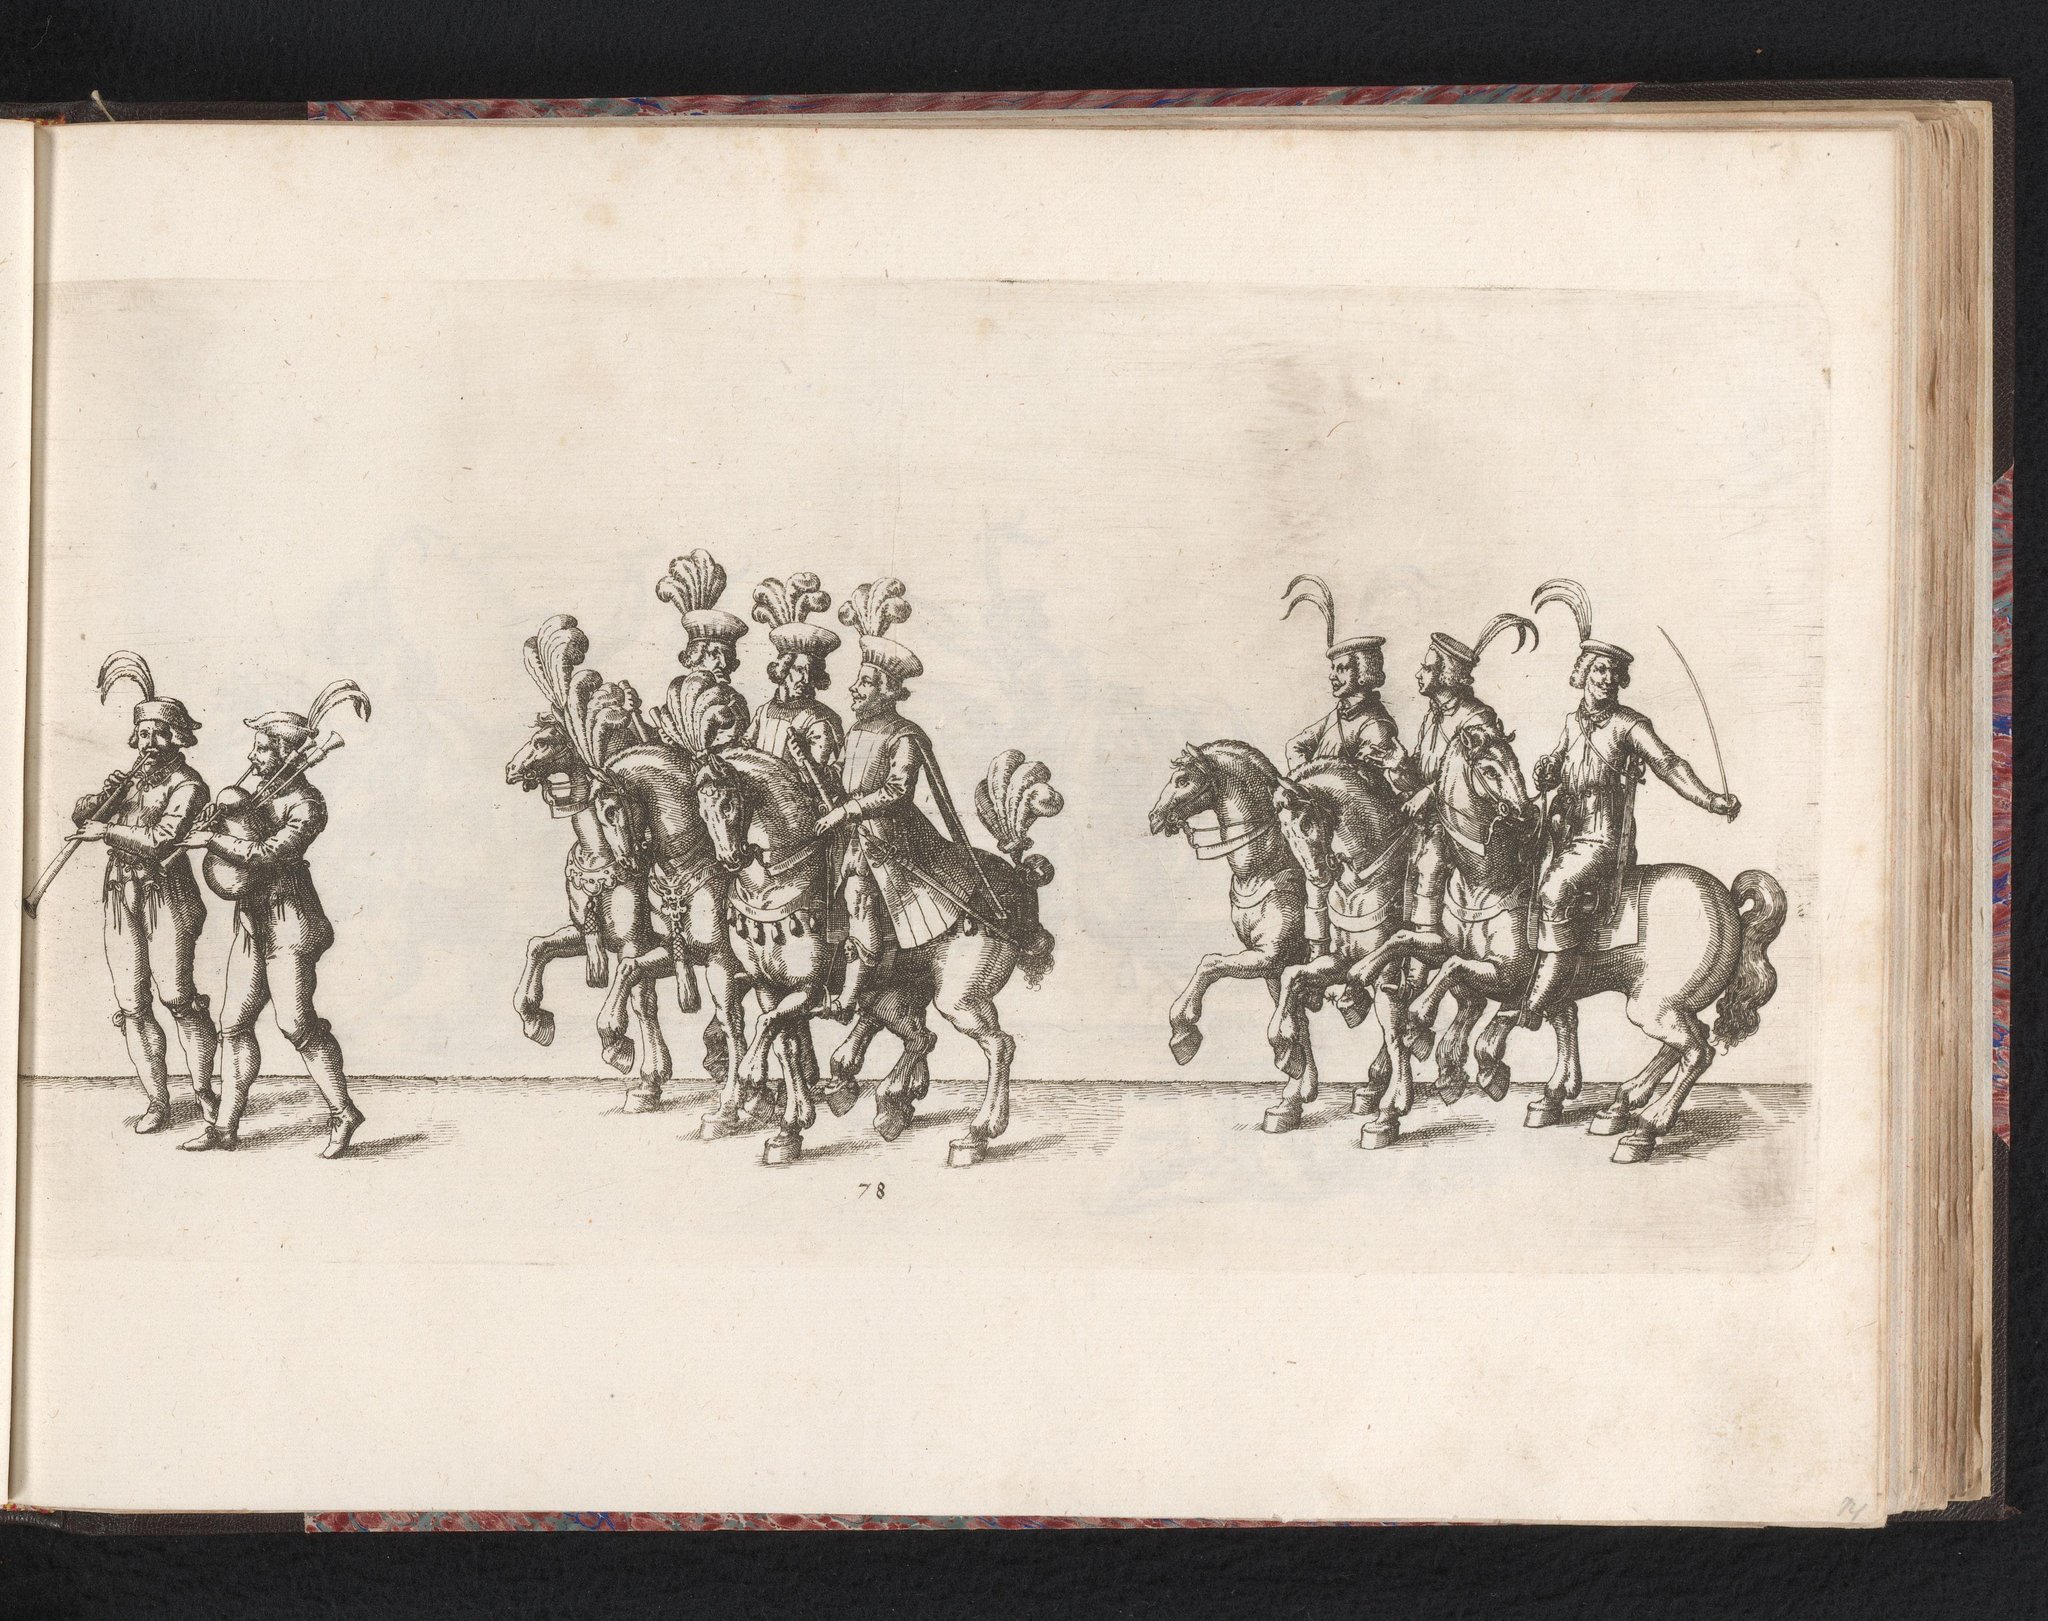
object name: print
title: Aigentliche wahrhaffte Delineation unnd Abbildung aller fürstlichen Auffzüg und Rütterspilen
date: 1618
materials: paper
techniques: etching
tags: musician - cc - out of doors, performance in the open air (pleasure fair), bagpipe, musette - cc - out of doors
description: Genummerd: 78. Deze prent maakt deel uit van een album.